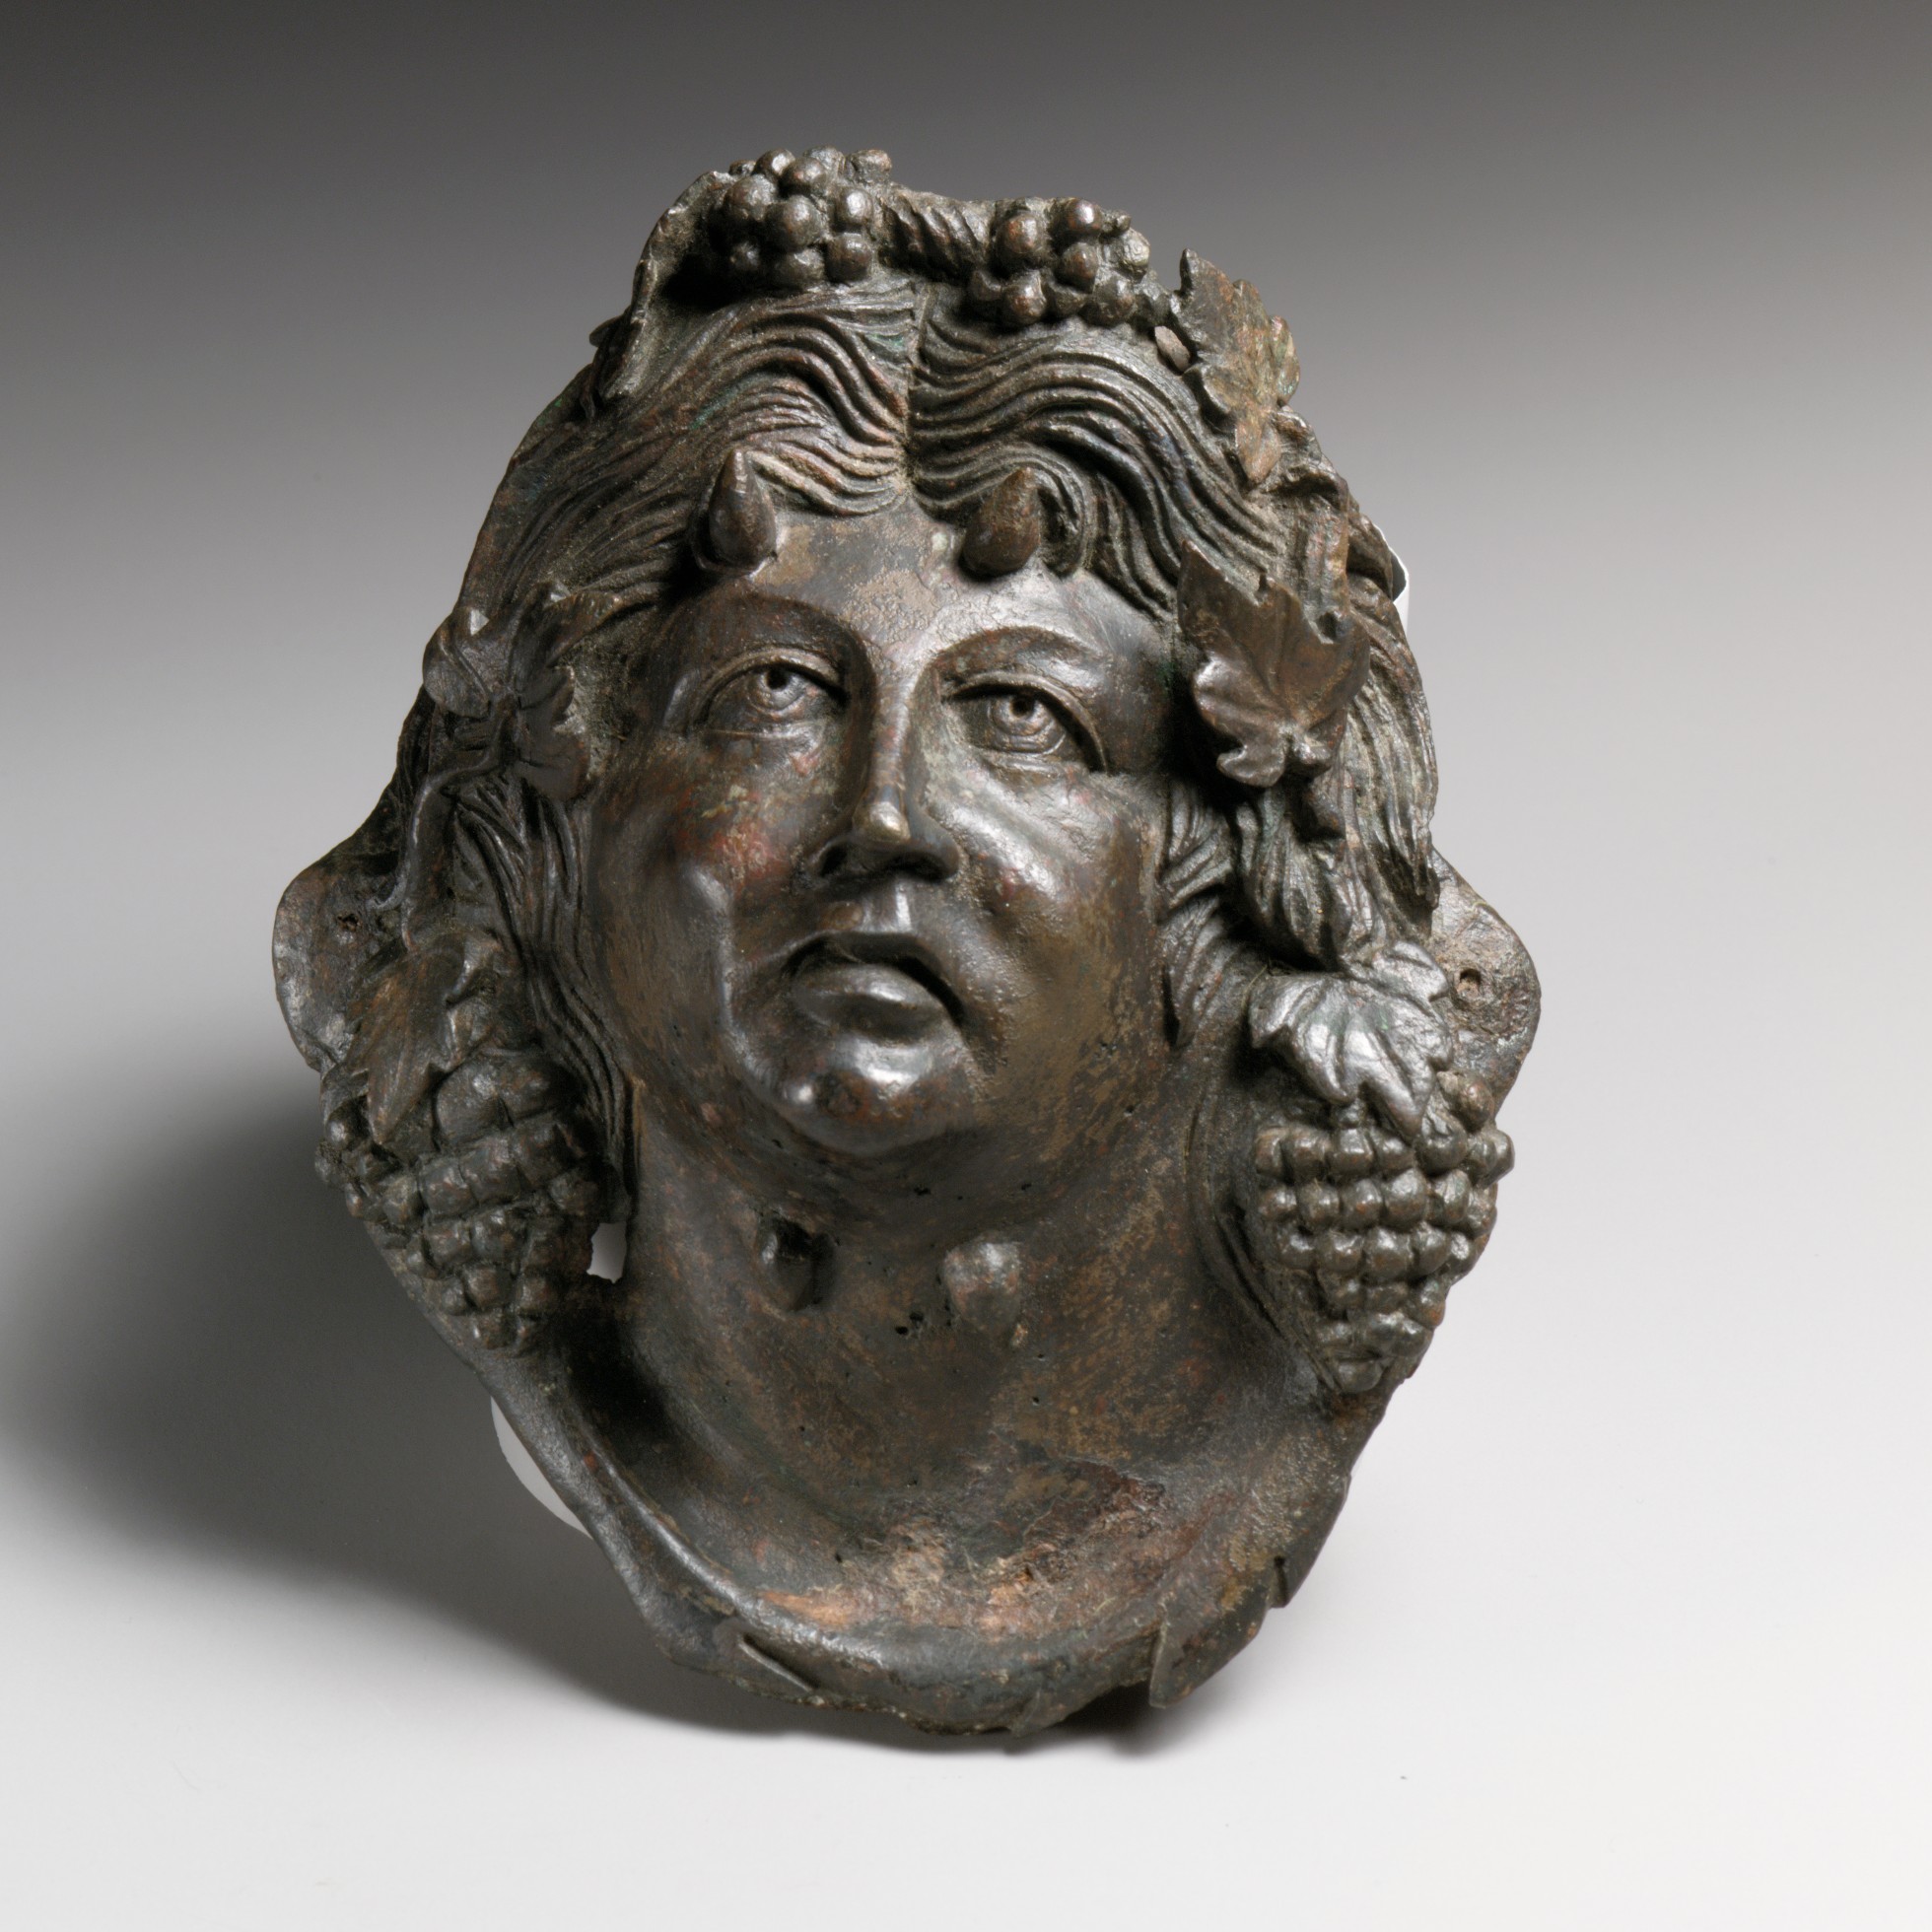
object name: head of a satyr, attachment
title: Bronze attachment in the form of the head of Pan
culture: roman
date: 100 BCE-200 CE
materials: bronze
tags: garlands,grapes,heads,men,leaves